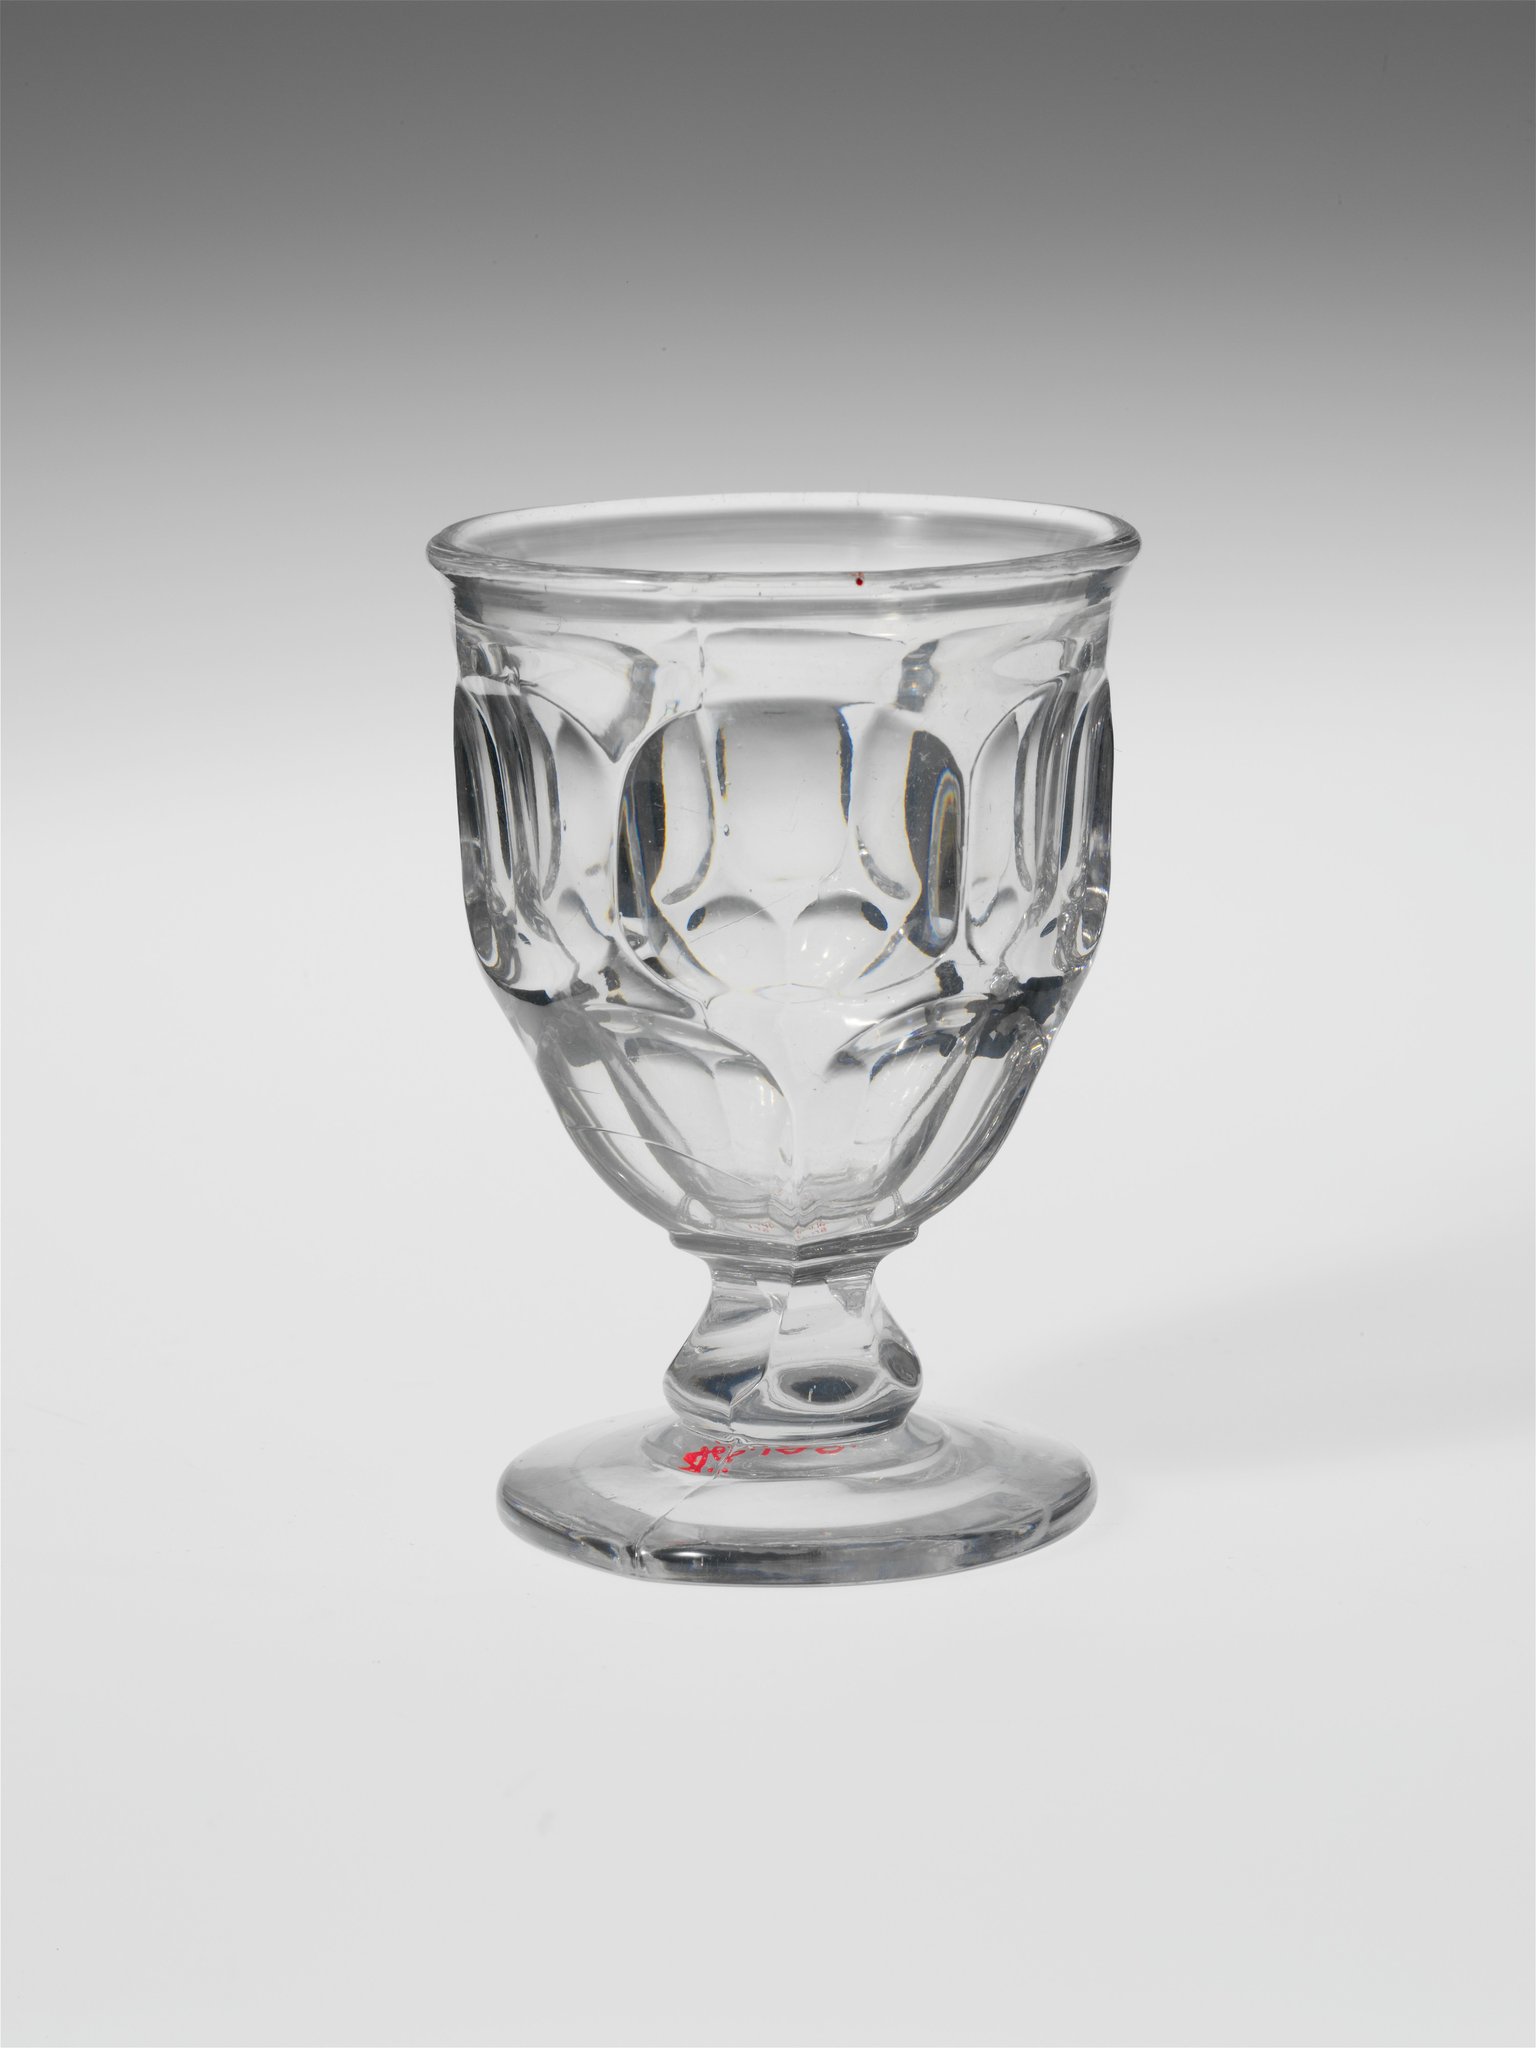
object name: egg cup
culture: american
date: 1830-1870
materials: glass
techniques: pressed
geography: united states